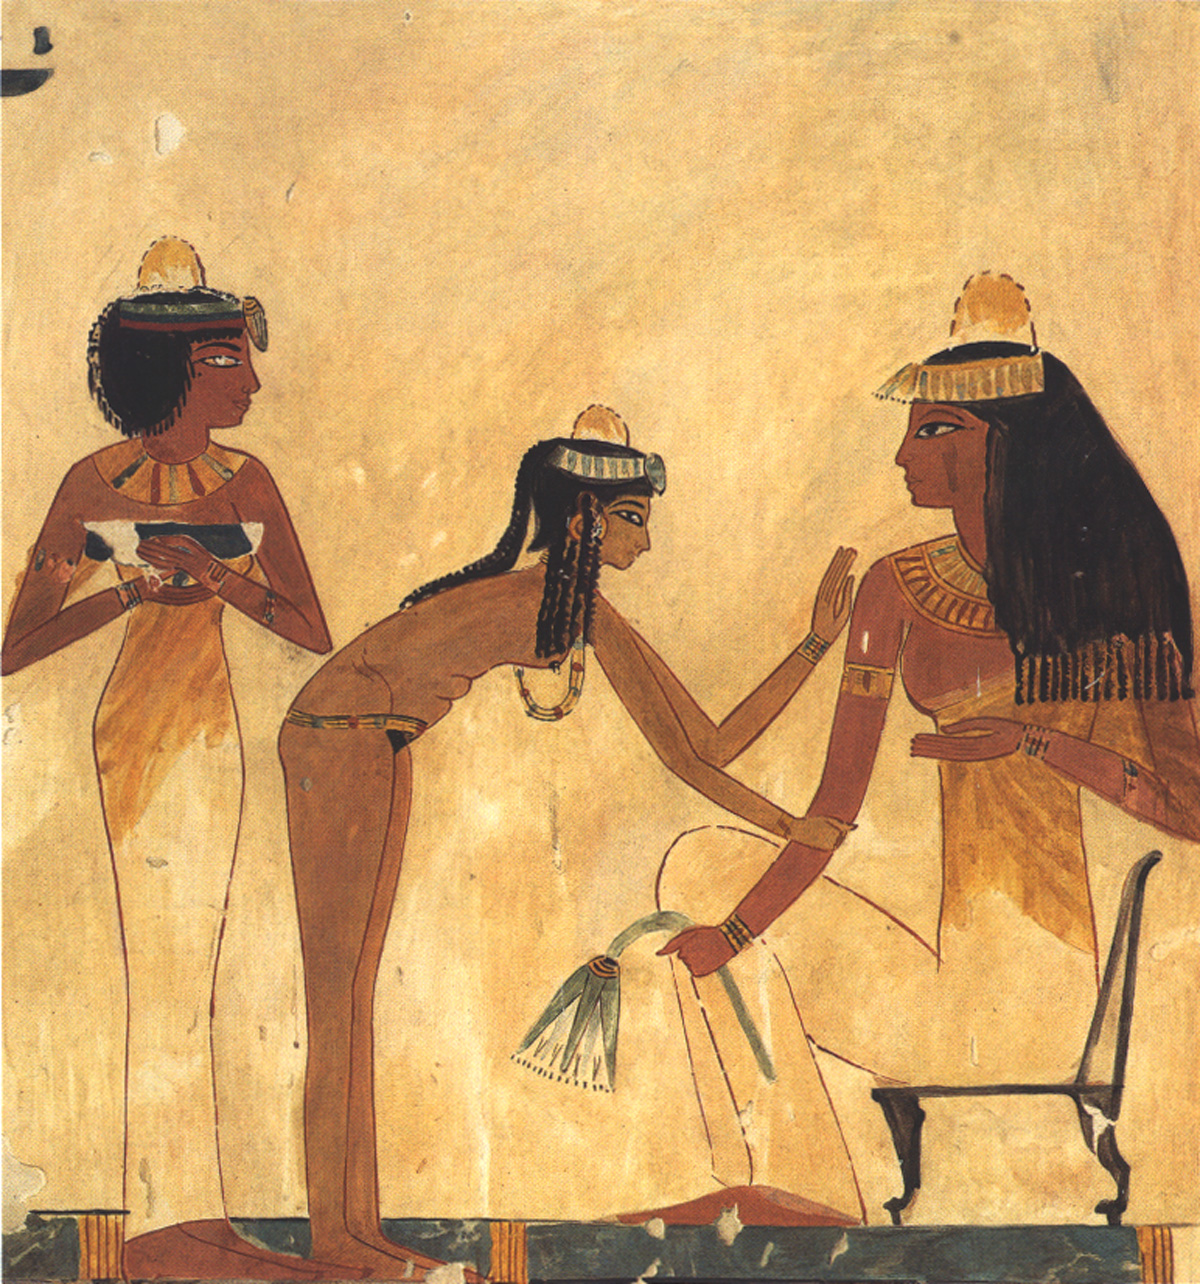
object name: facsimile, djeserkareseneb tt 38, banquet, chair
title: Seated woman with Two Female Servants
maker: charles k. wilkinson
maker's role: artist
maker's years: 1897-1986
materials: paper, paint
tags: women,female nudes